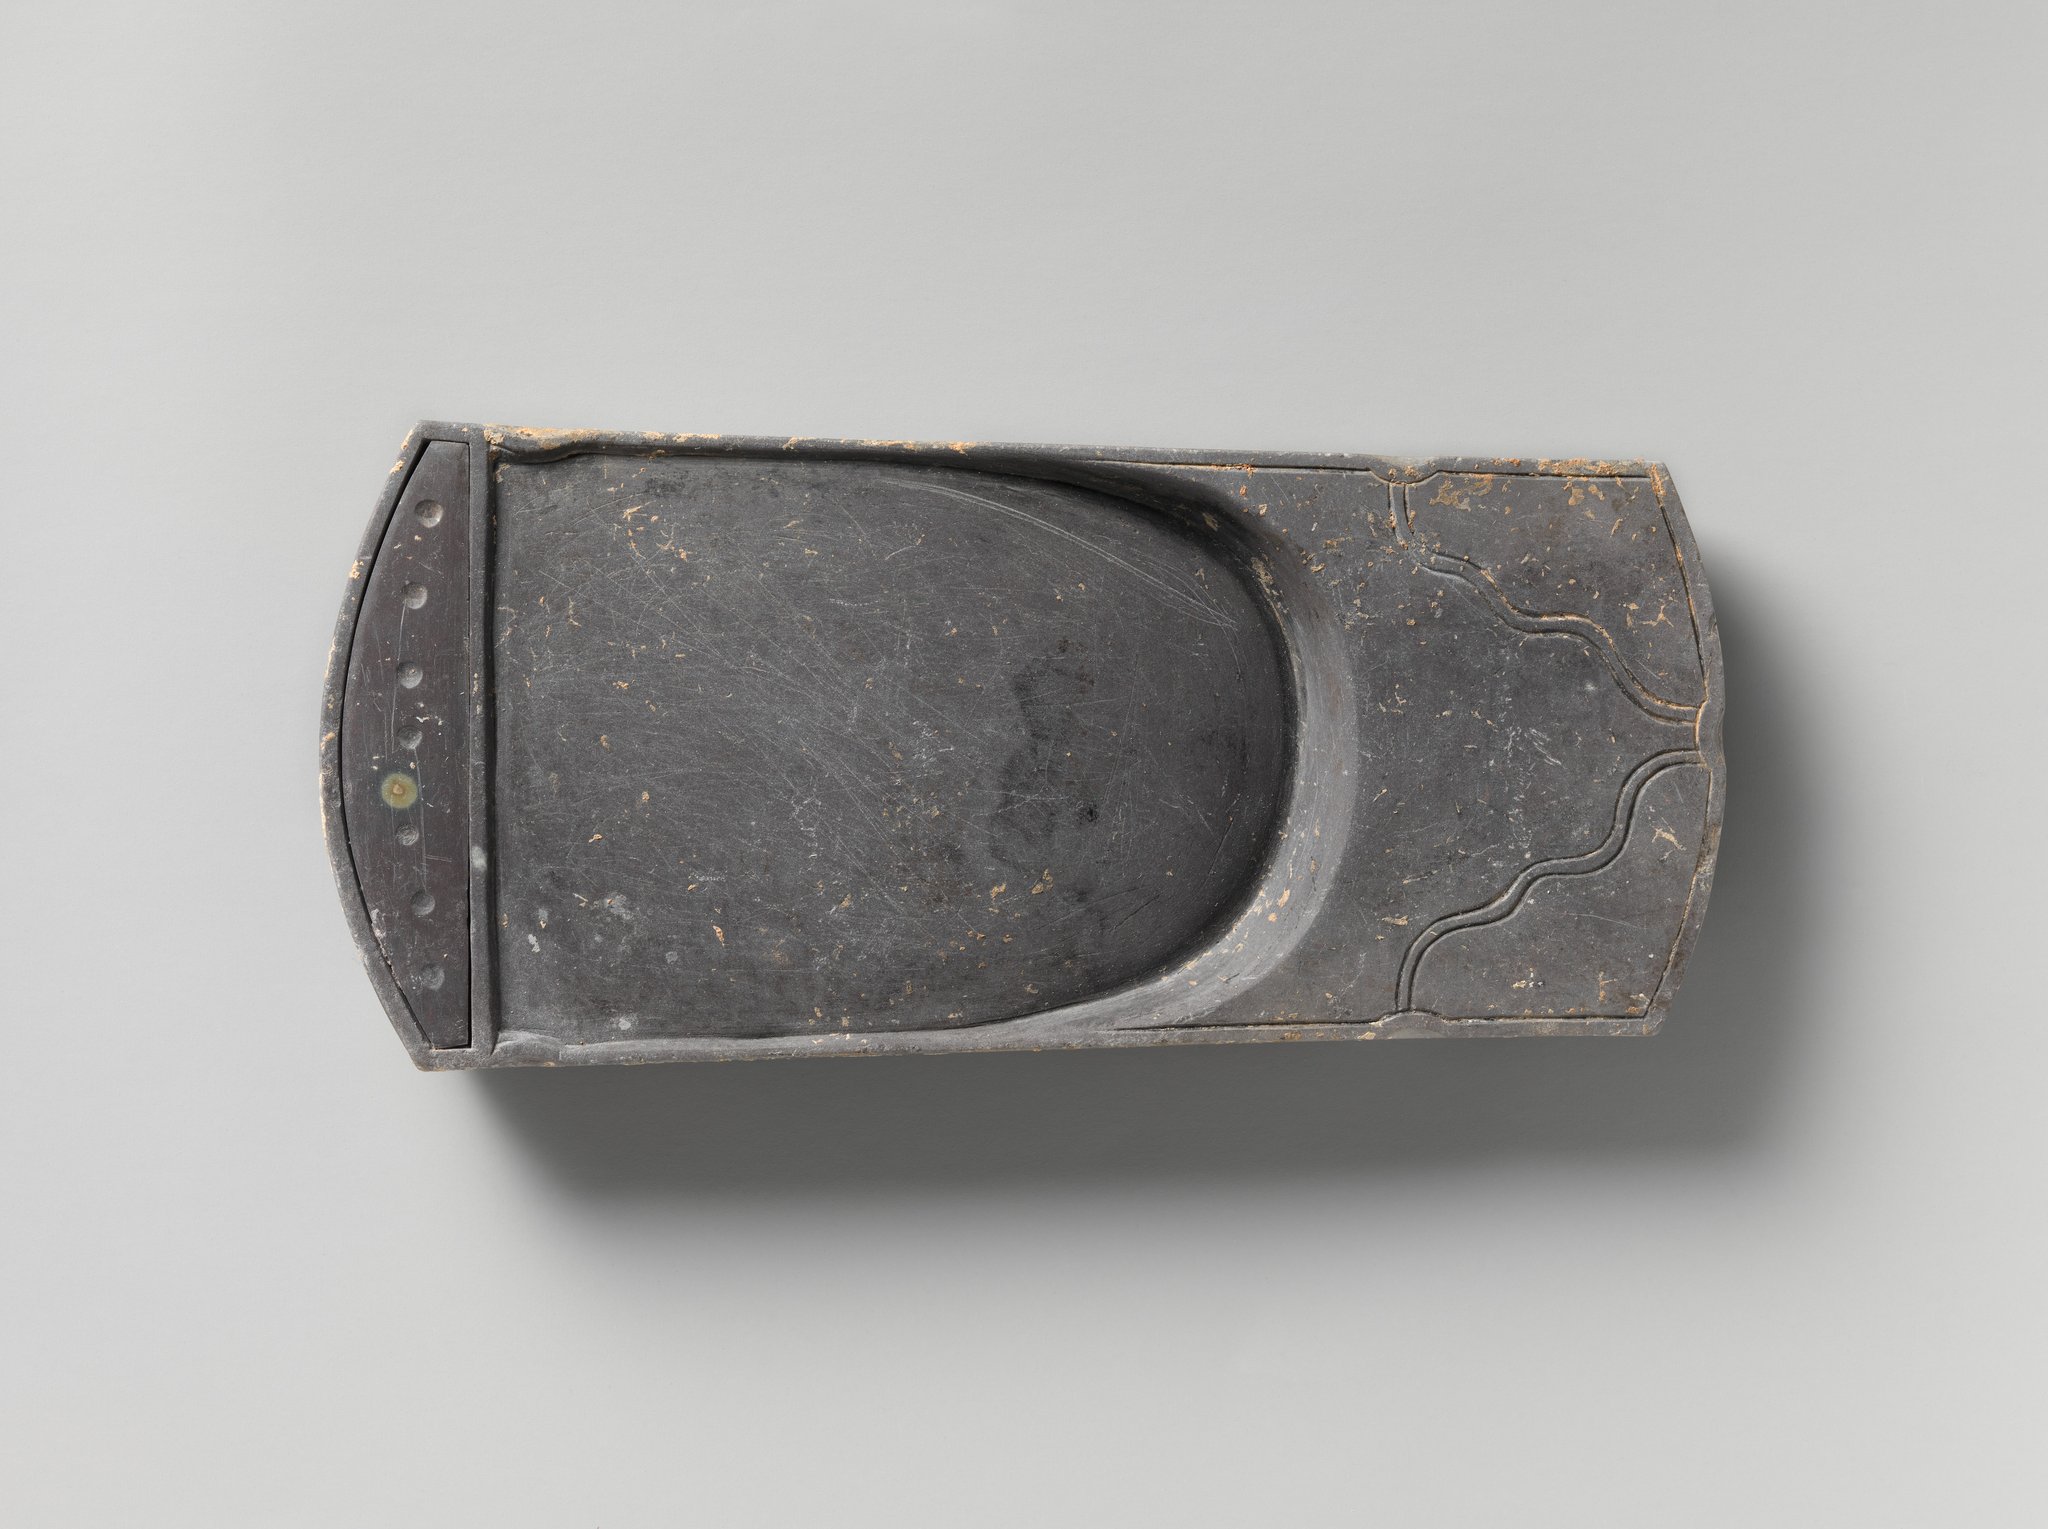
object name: inkstone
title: Inkstone in the Form of a Qin (Zither)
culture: chinese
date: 960-1279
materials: stone